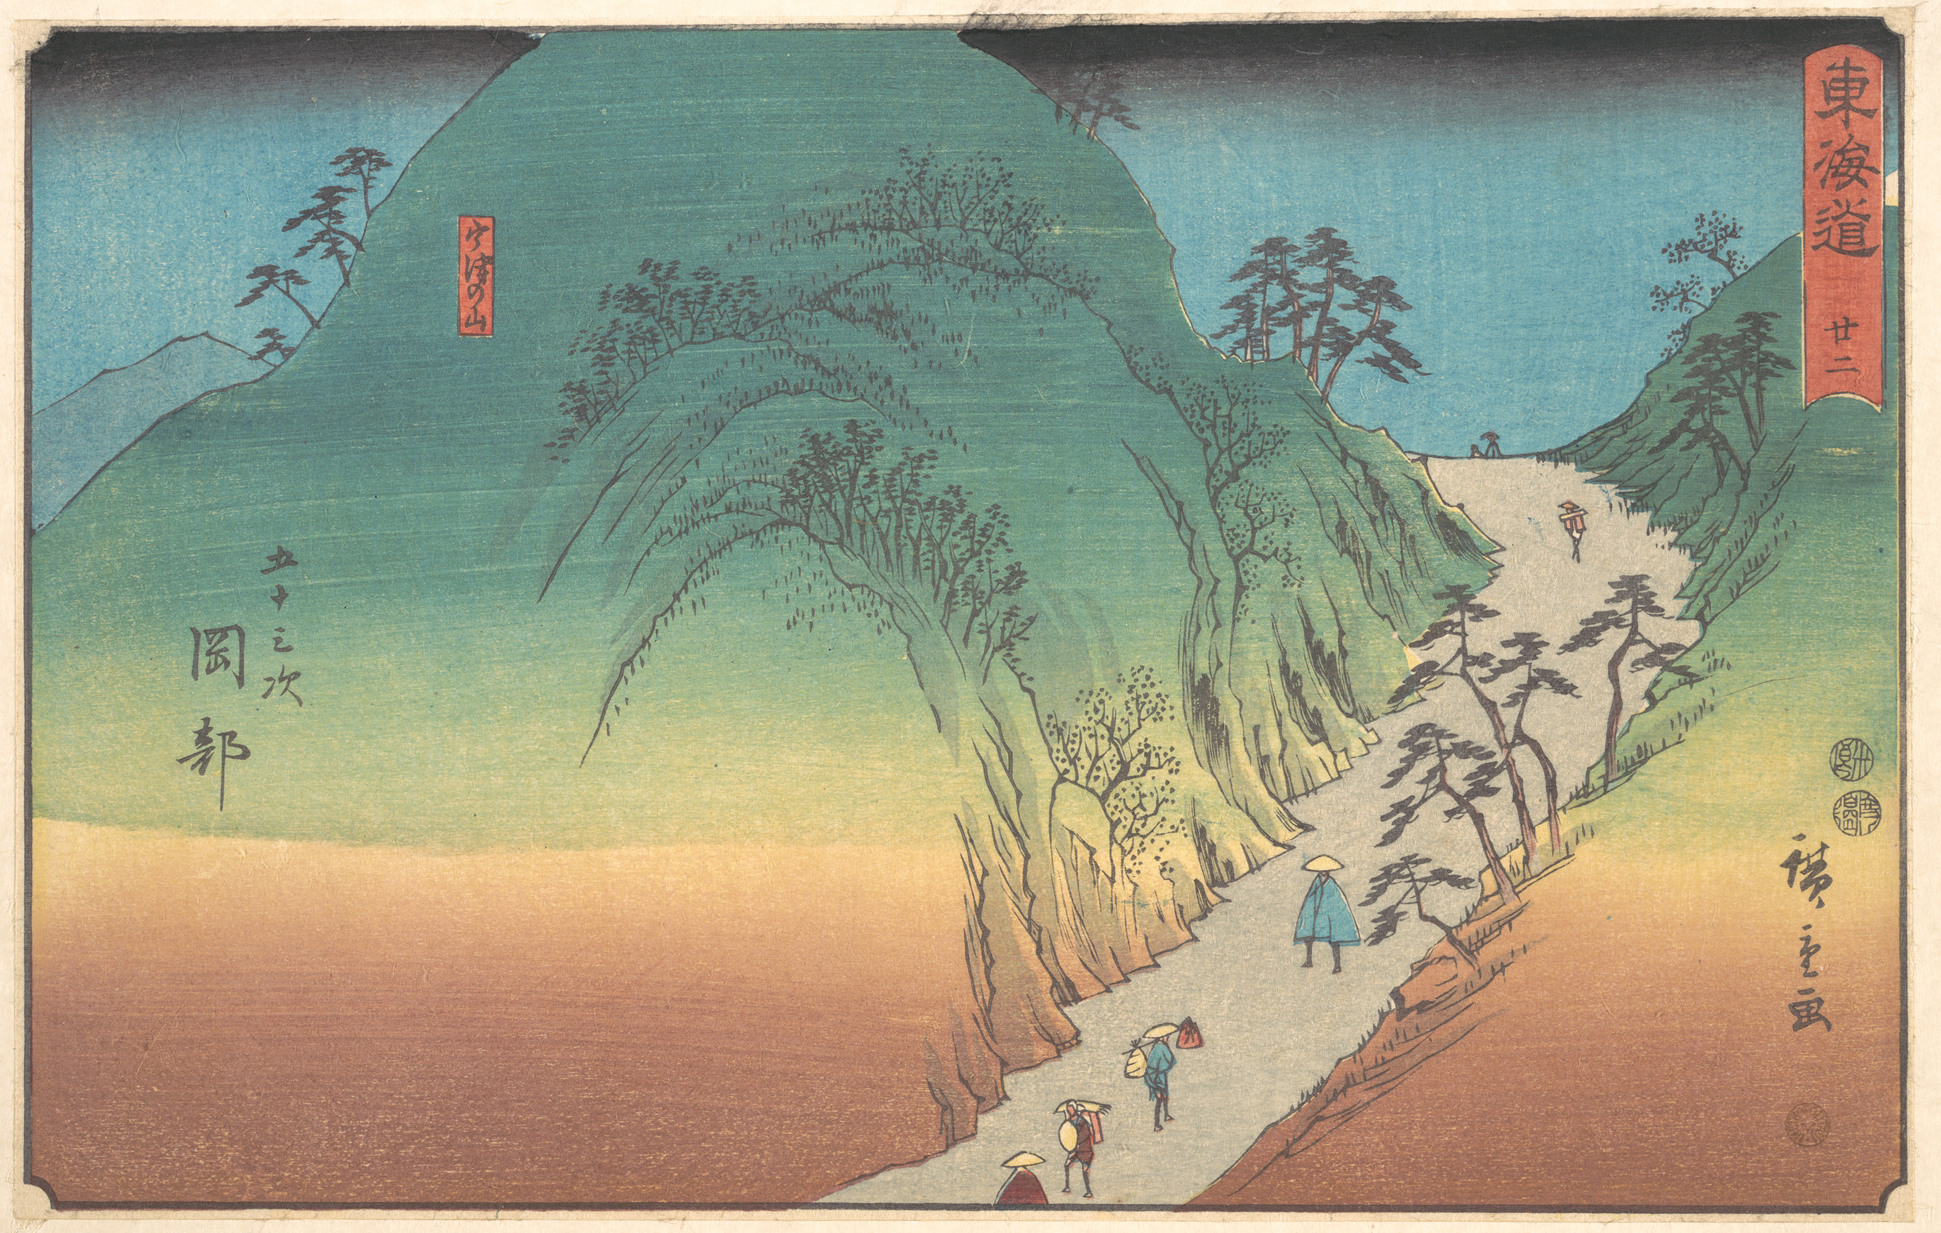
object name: print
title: Okabe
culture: japanese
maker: utagawa hiroshige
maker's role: artist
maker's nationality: japanese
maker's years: 1797-1858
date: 1840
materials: ink, paper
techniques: woodblock print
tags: human figures,roads,mountains,trees